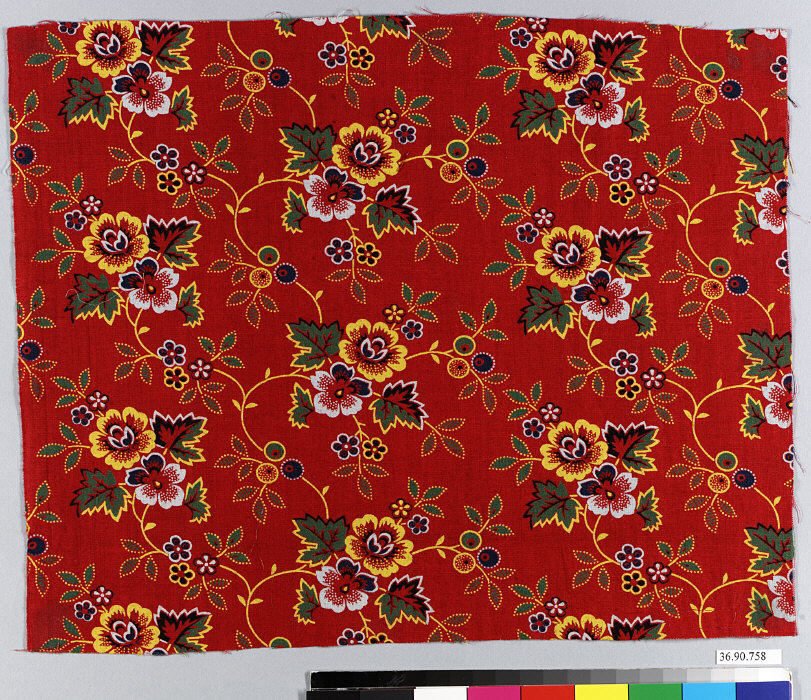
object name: piece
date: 1867-1900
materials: cotton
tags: flowers,leaves